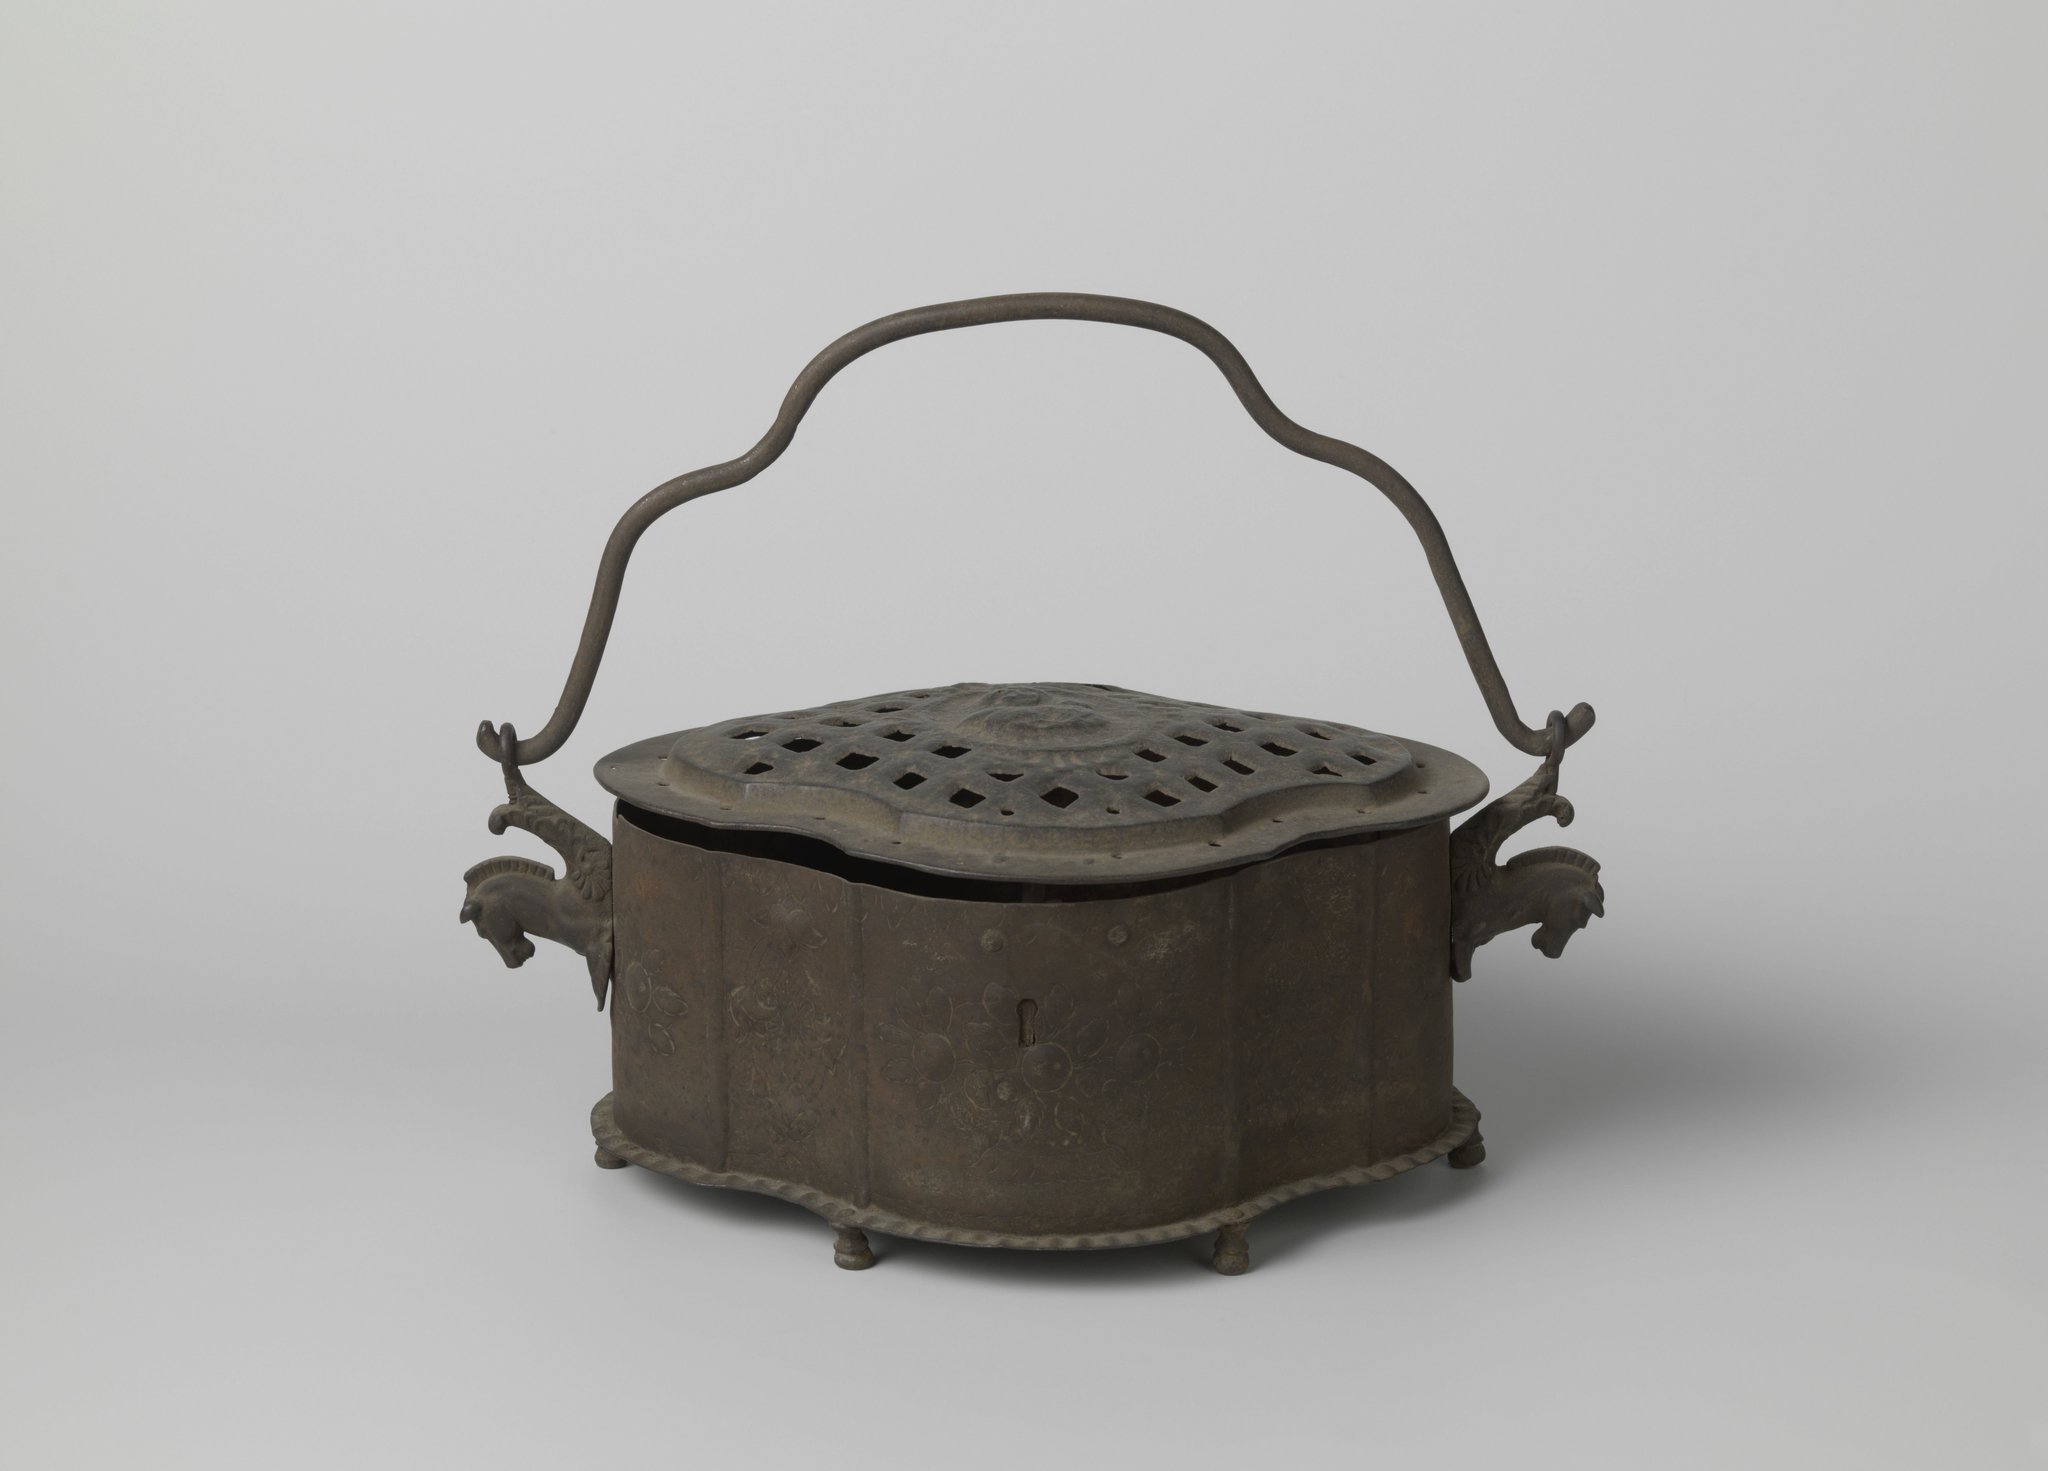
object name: voetstoof, stoof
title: Stoof van gesmeed ijzer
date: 1625-1675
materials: iron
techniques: forging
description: Een langwerpige stoof van gesmeed ijzer. Het ajour gewerkt deksel vertoont als medaillon in het midden en menselijke buste met een kind. De randen zijn met vruchten en reliëf enz. opgewerkt. Het hengsel is door twee zeepaarden aan de bak bevestigd.